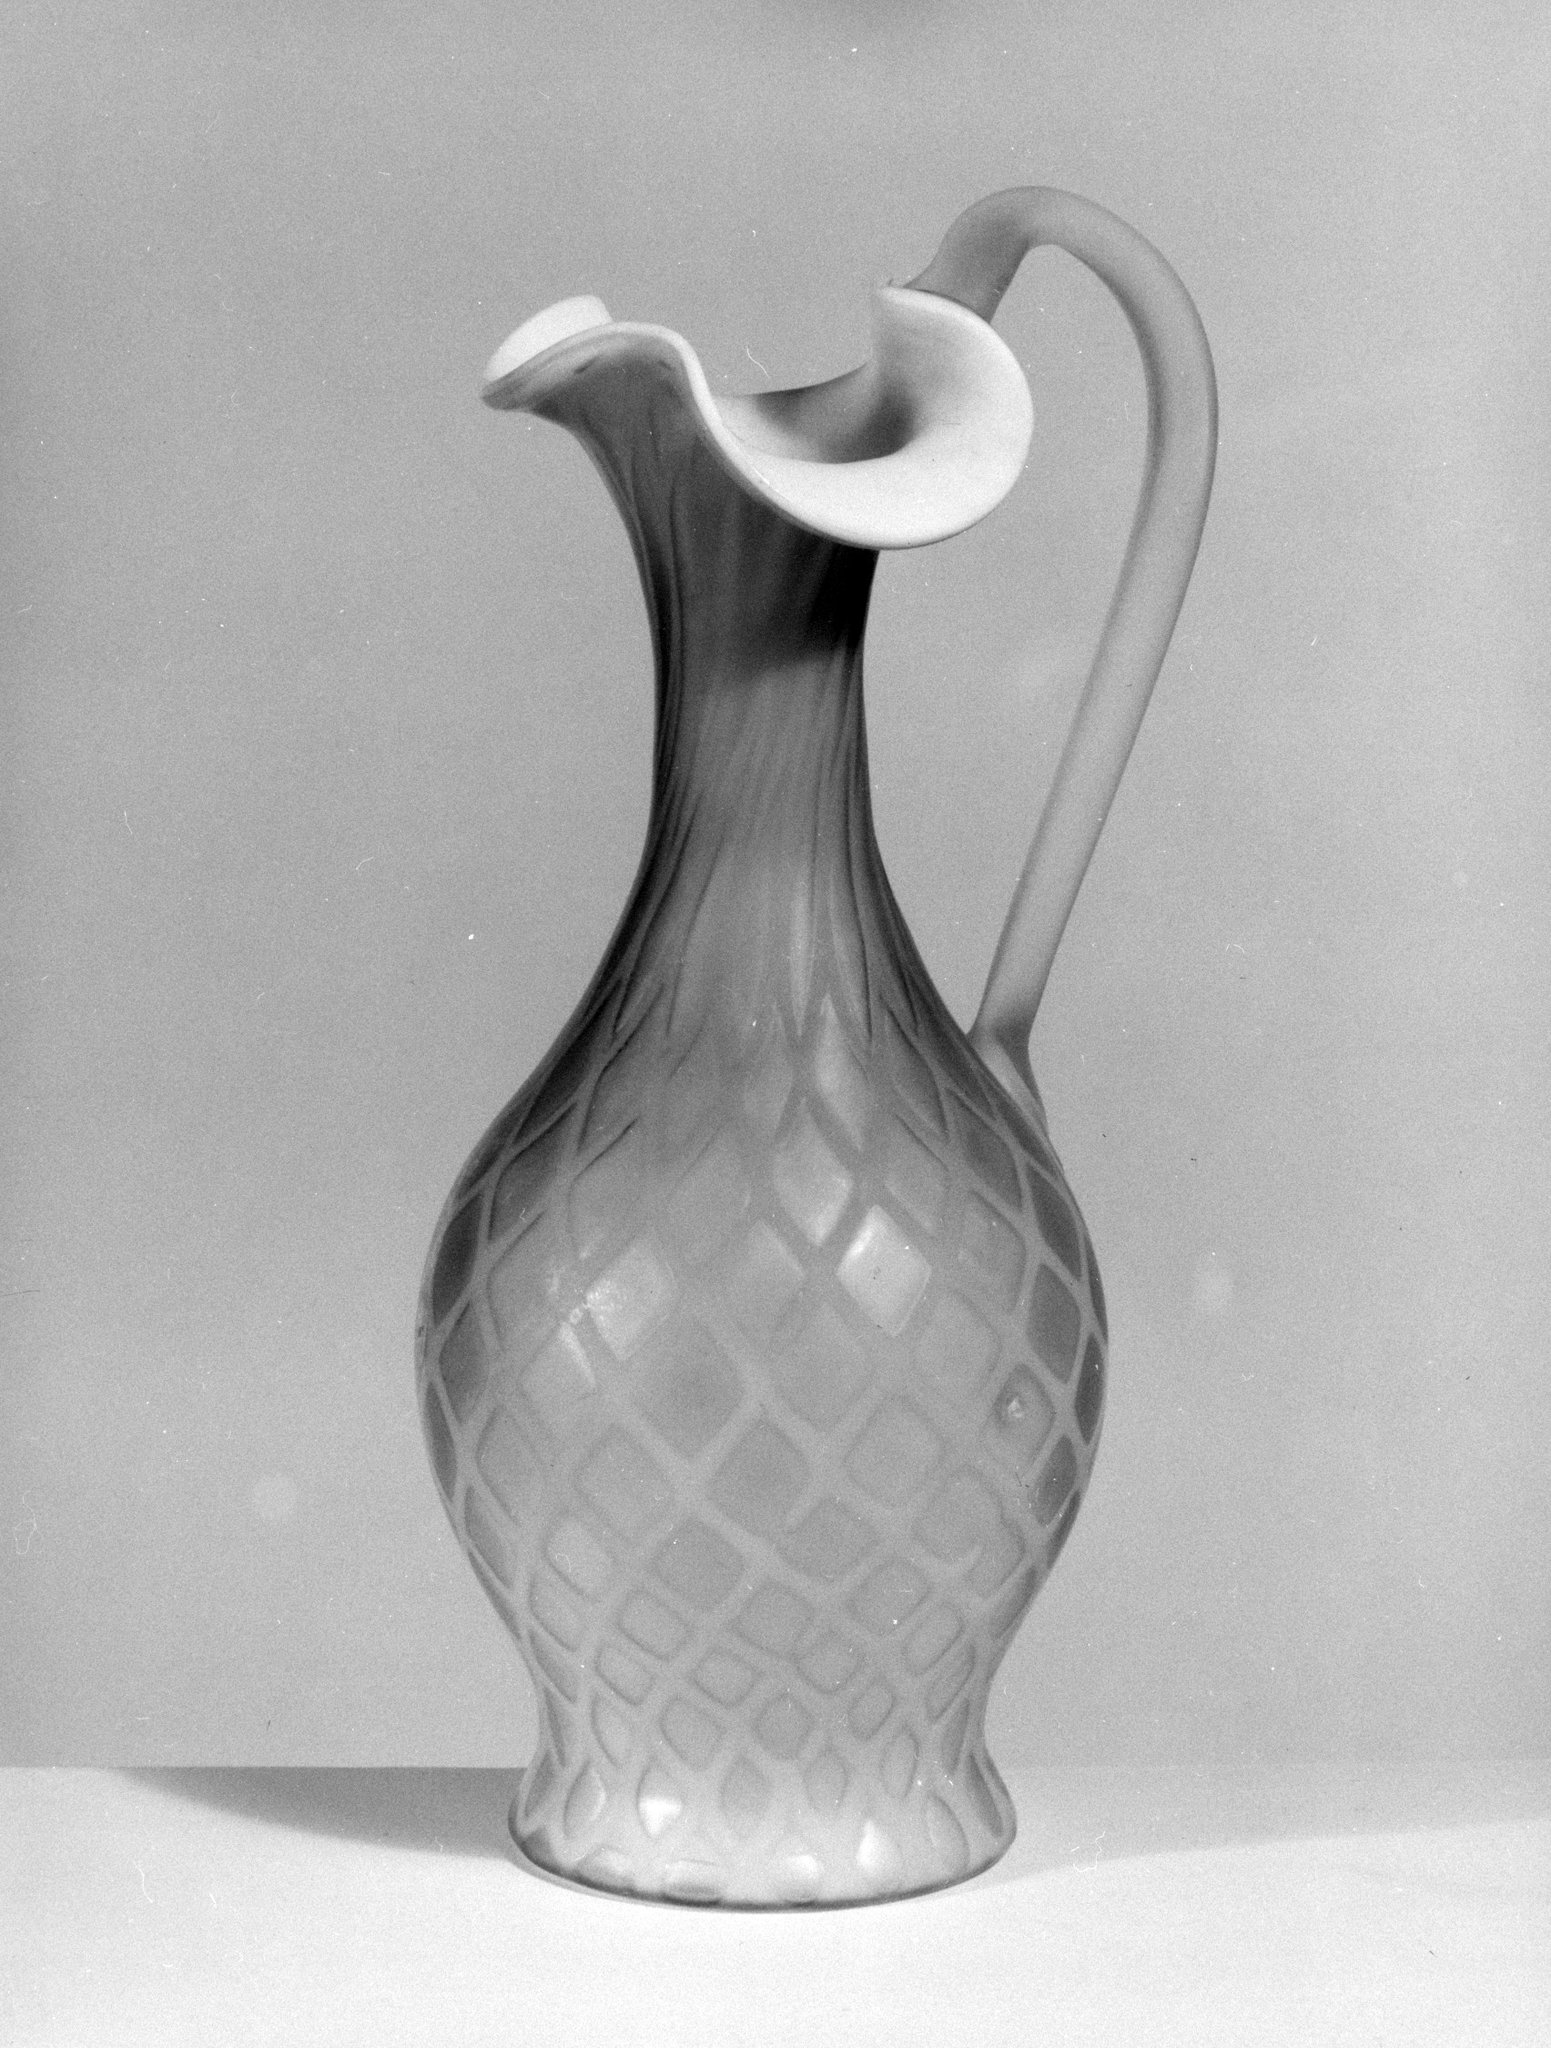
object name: ewer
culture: british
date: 1885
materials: amber, glass, textile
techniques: glassblowing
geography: england